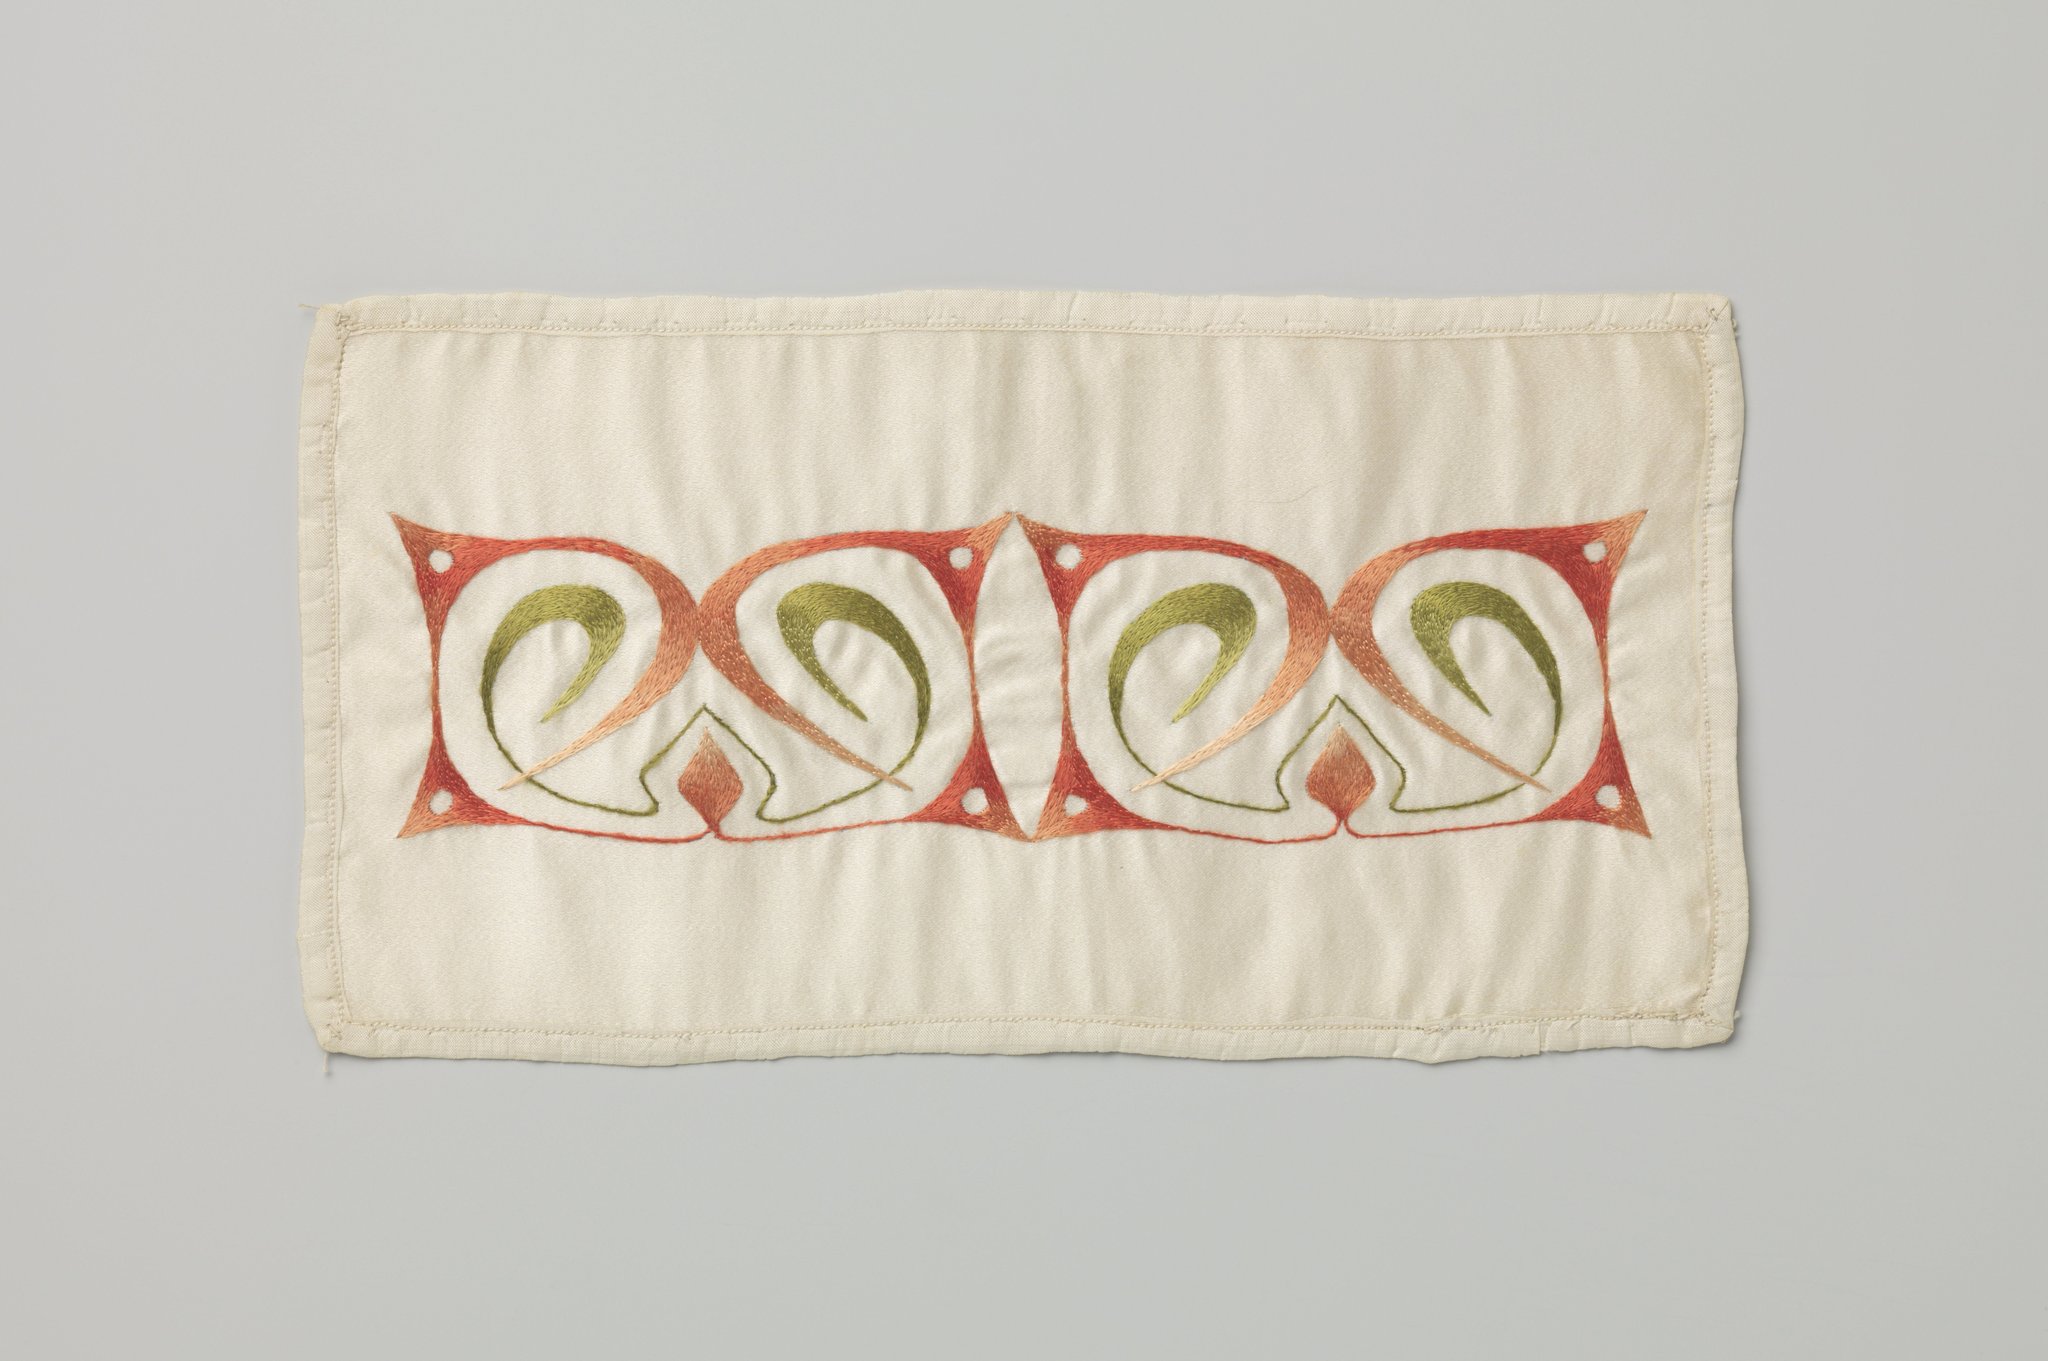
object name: handwerk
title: Handwerk met Jugendstilmotief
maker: aagje tiket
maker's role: artisan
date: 1900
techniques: embroidered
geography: amsterdam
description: Handwerk met Jugendstil randmotief in rood en mosgroen, in de ingrijpsteek, op wit satijnen rechthoek. Behorend tot serie van acht witte en tien gekleurde handwerken, vervaardigd door Aagje Tiket voor het behalen van de akte Fraaie en/of Nuttige handwerken aan de Industrieschool, BK-1974-105-A t/m R.